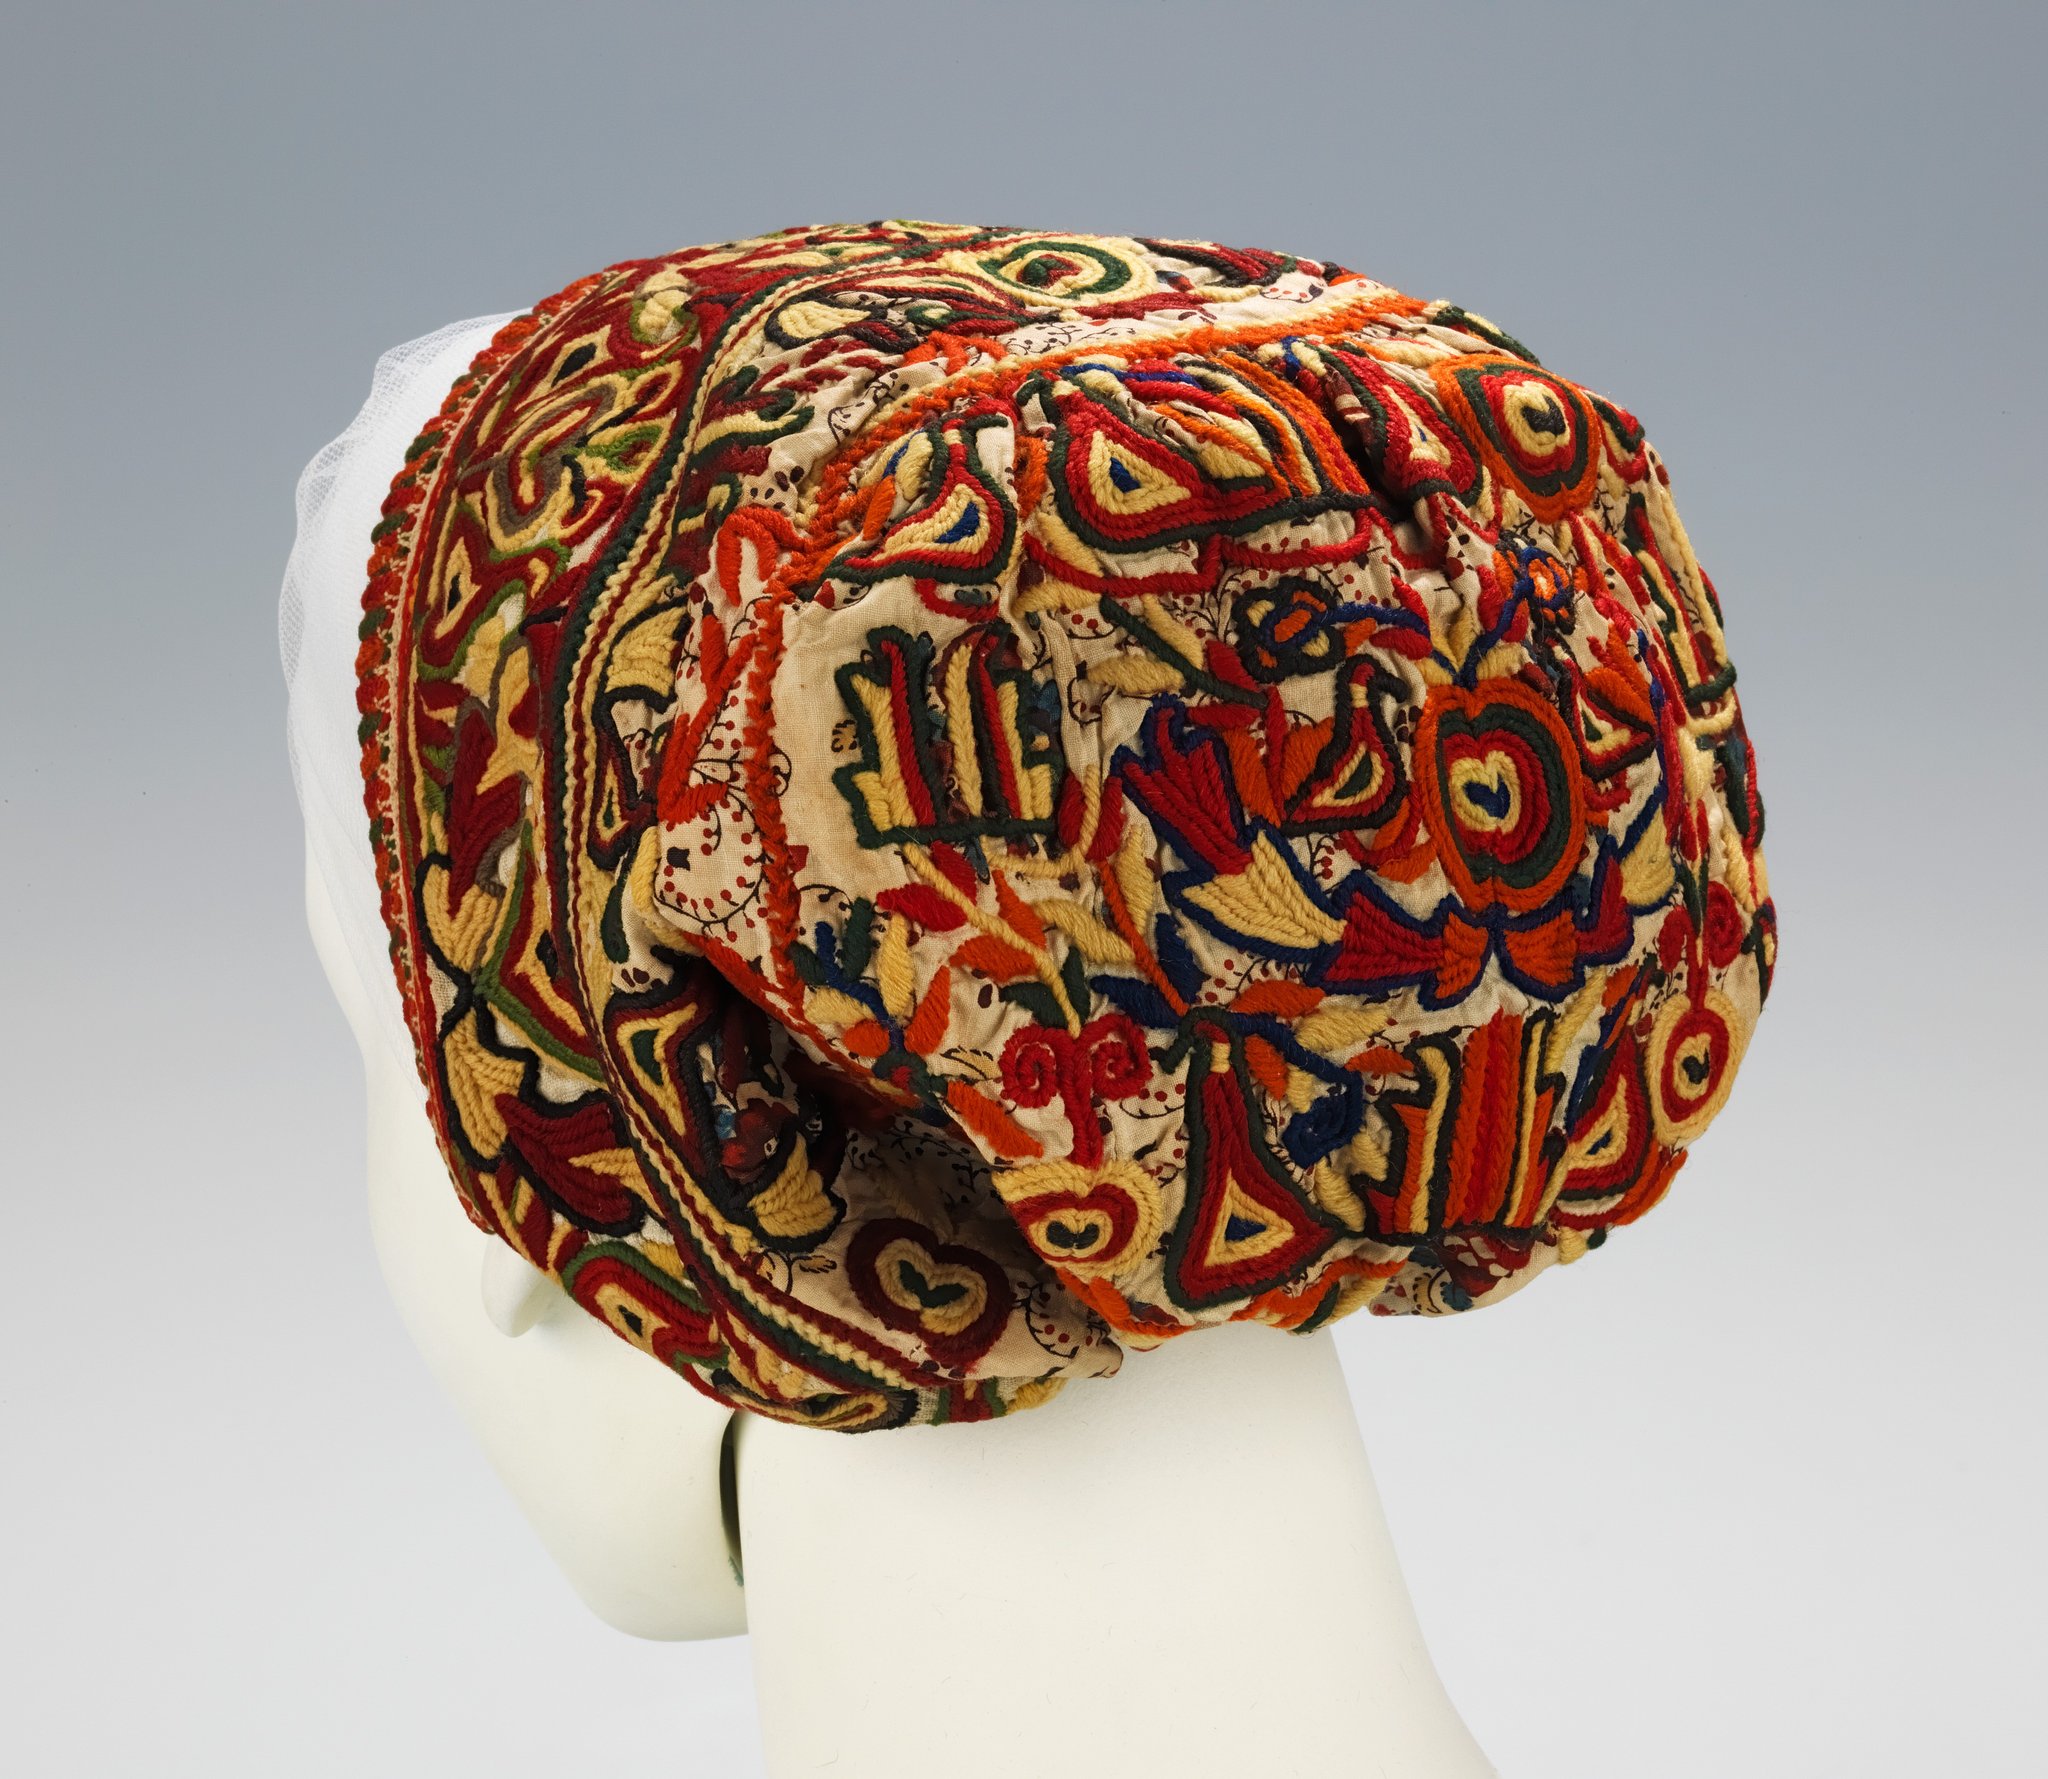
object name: cap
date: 1840-1870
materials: cotton, wool